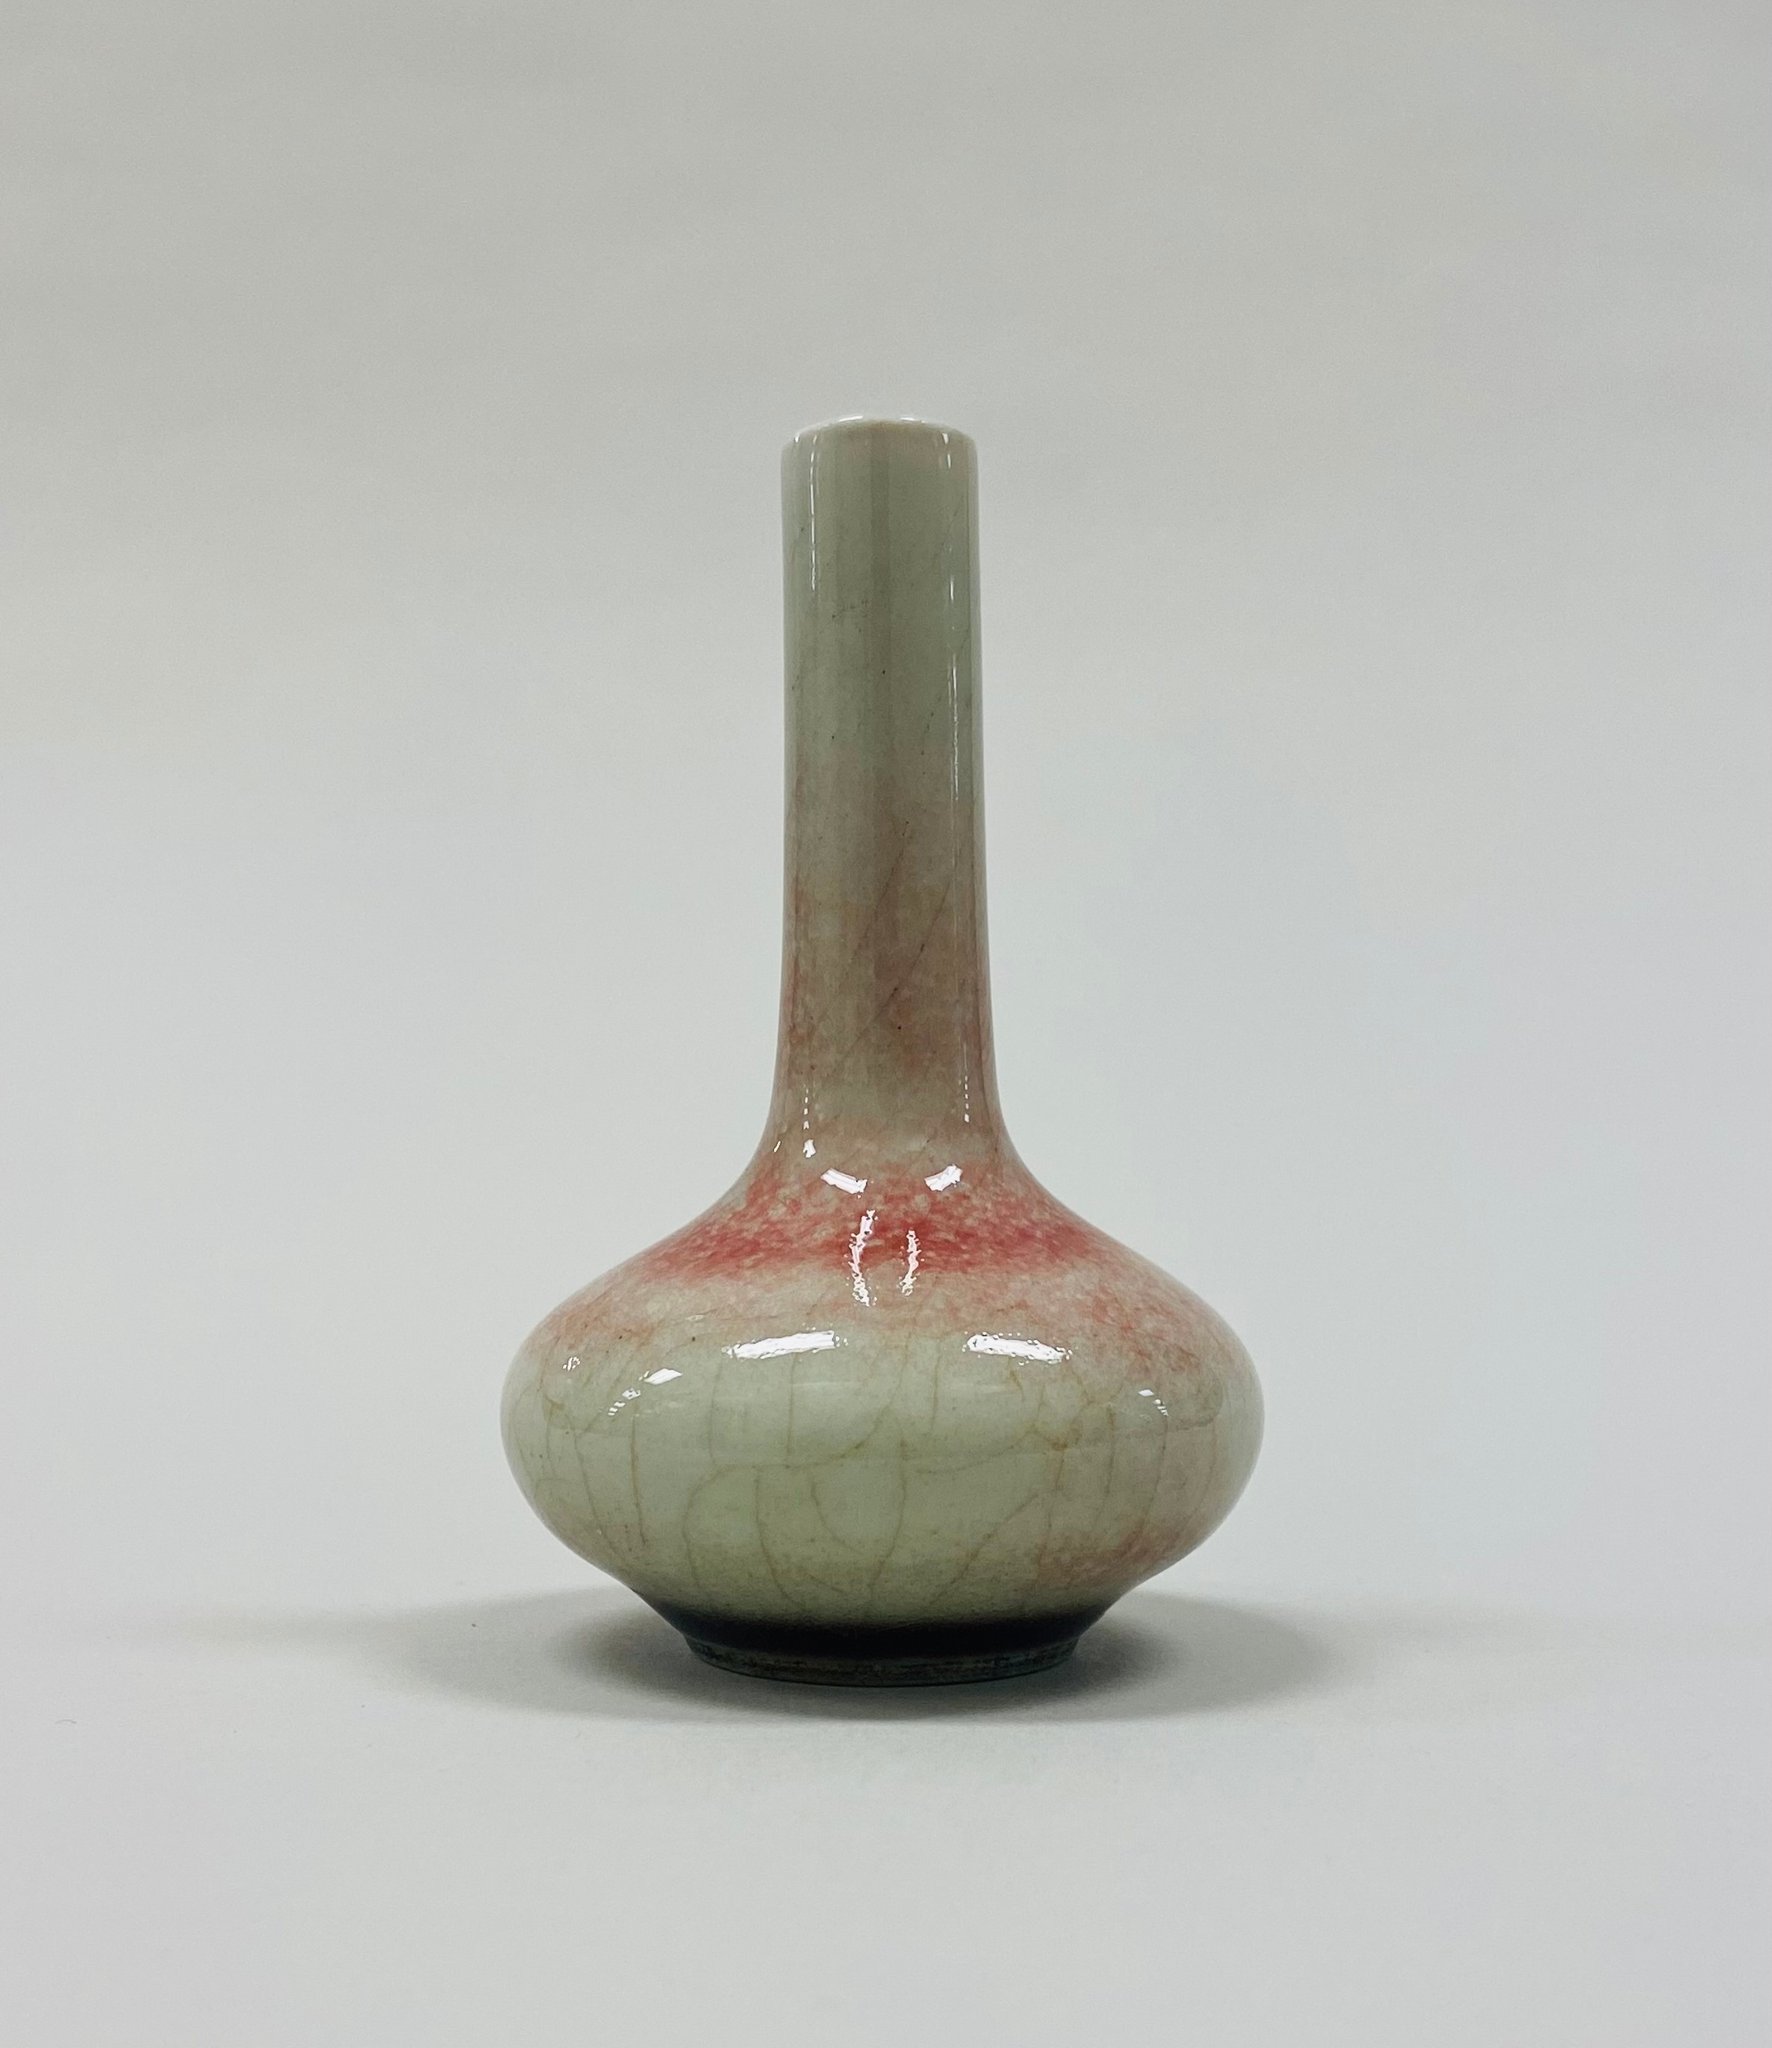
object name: vase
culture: chinese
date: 1701-1800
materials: copper, glaze, porcelain